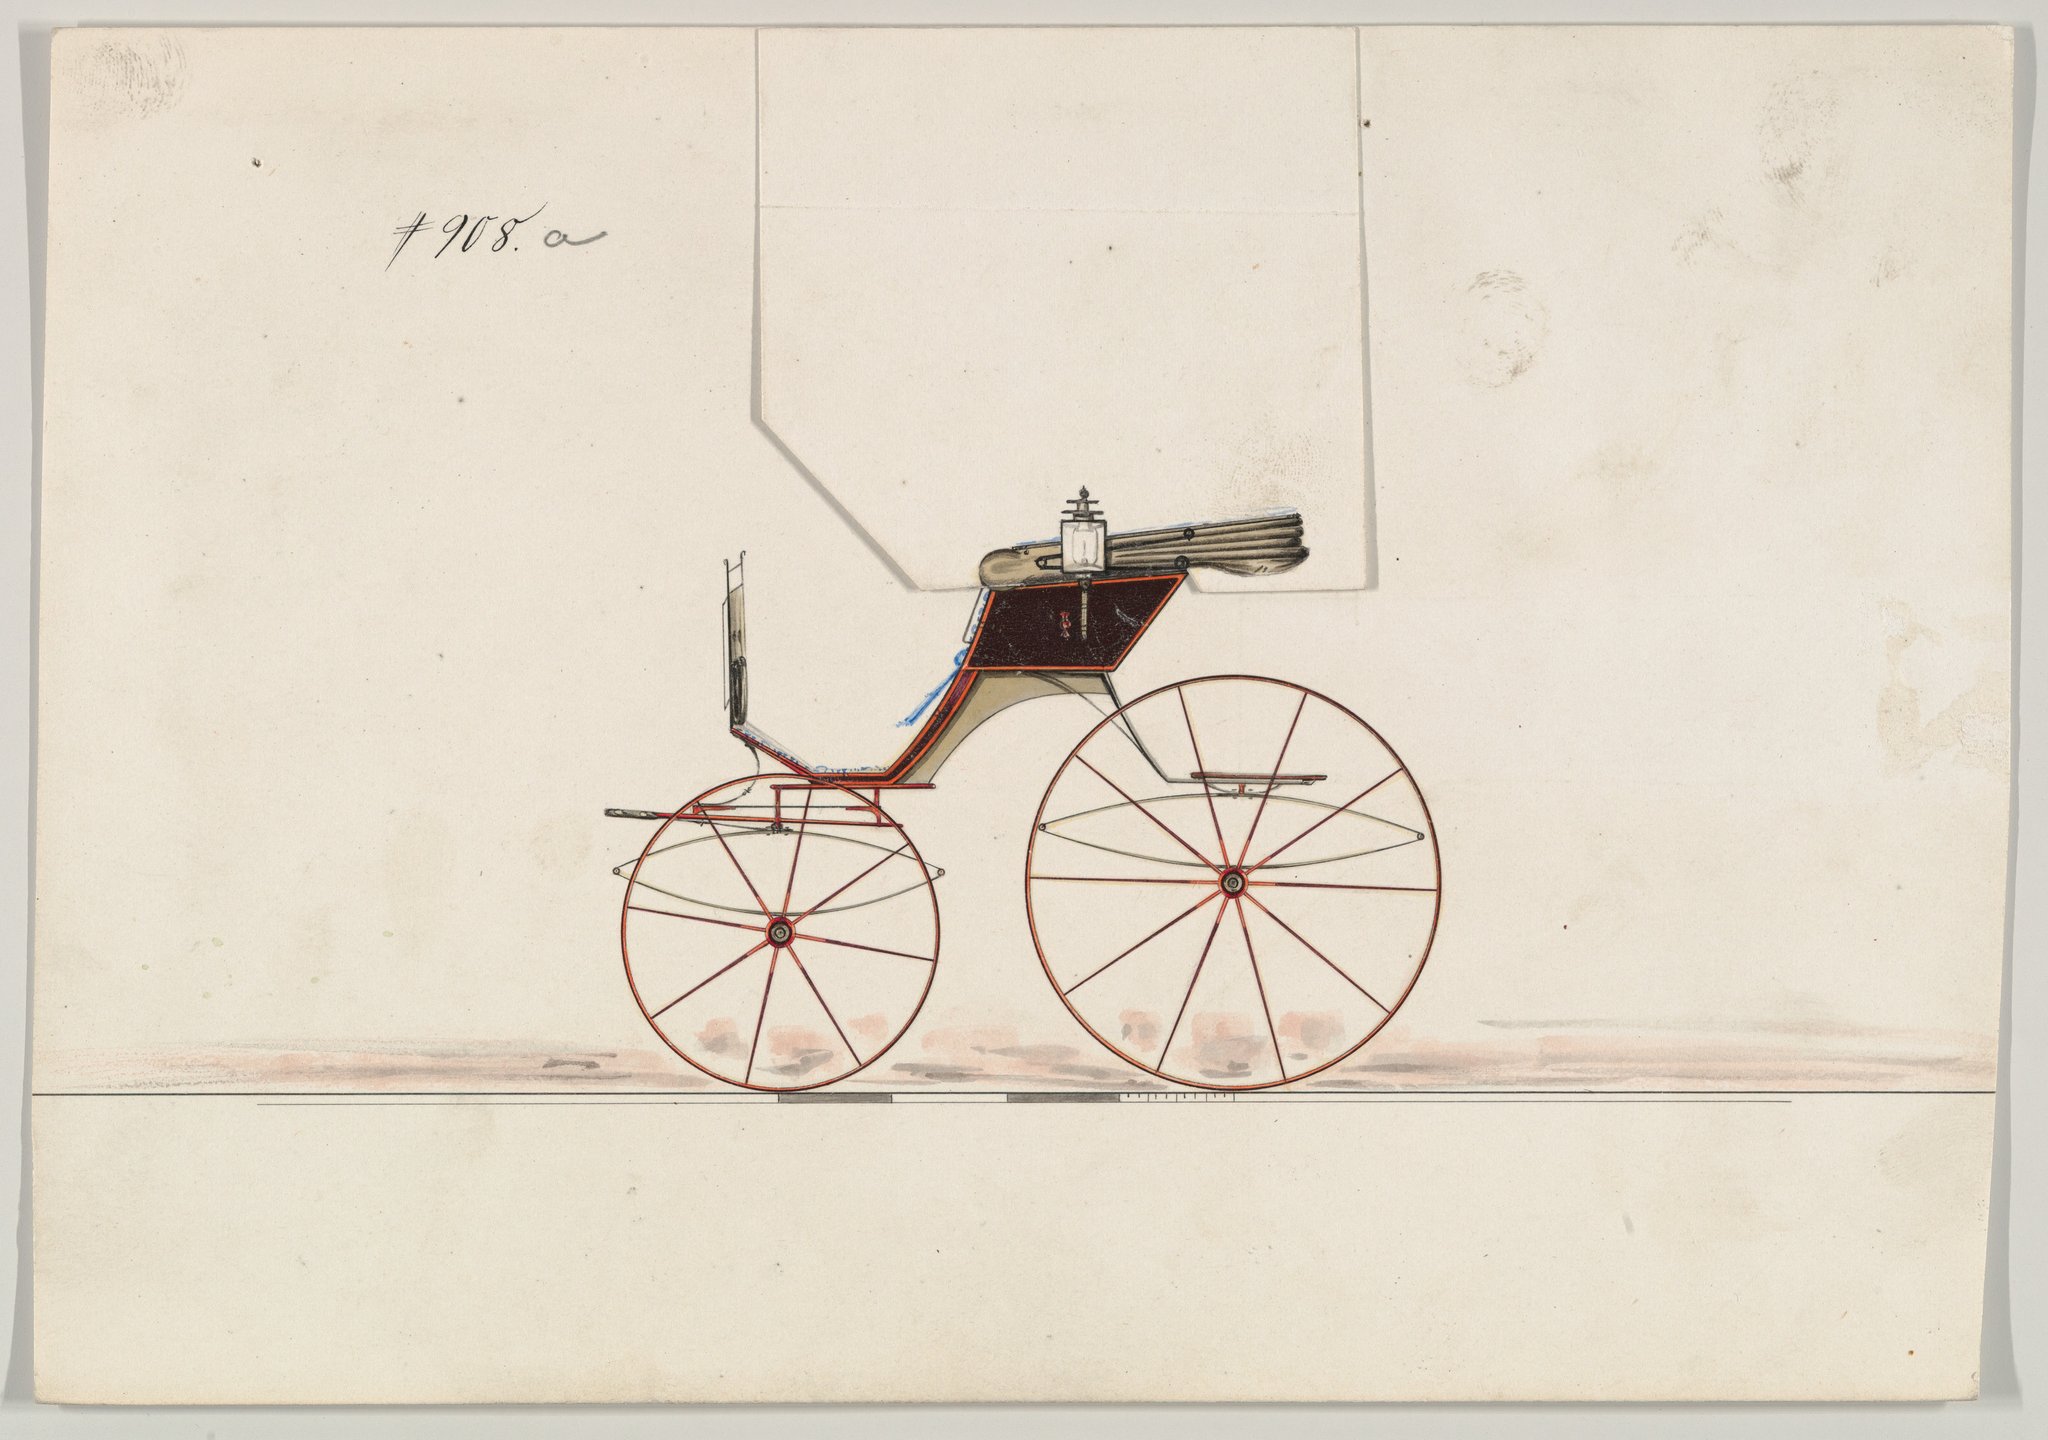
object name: drawing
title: Four-spring Drop Front Road Wagon #908a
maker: brewster & co.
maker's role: manufacturer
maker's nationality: american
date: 1850-1870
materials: gouache, gum arabic, ink, watercolor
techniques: pen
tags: carriages